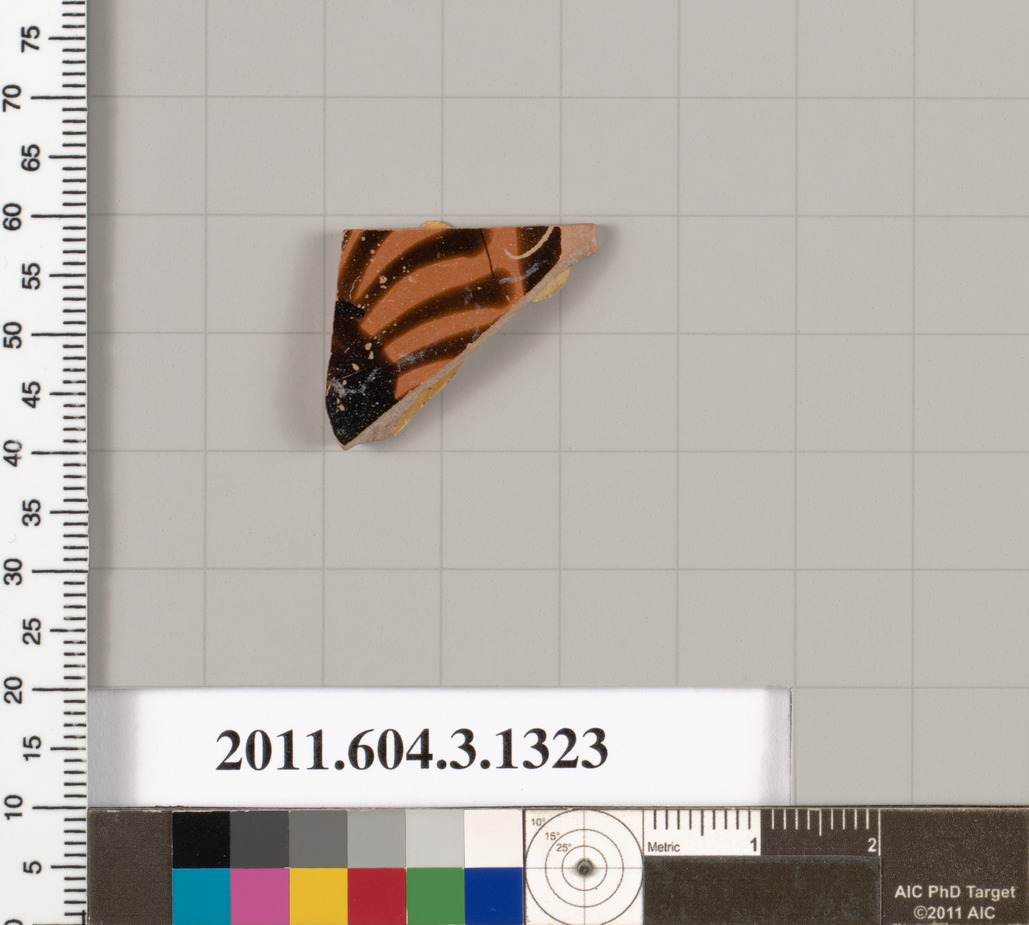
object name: skyphos fragment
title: Terracotta fragment of a skyphos (deep drinking cup)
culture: greek, attic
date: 490-480 BCE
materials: terracotta